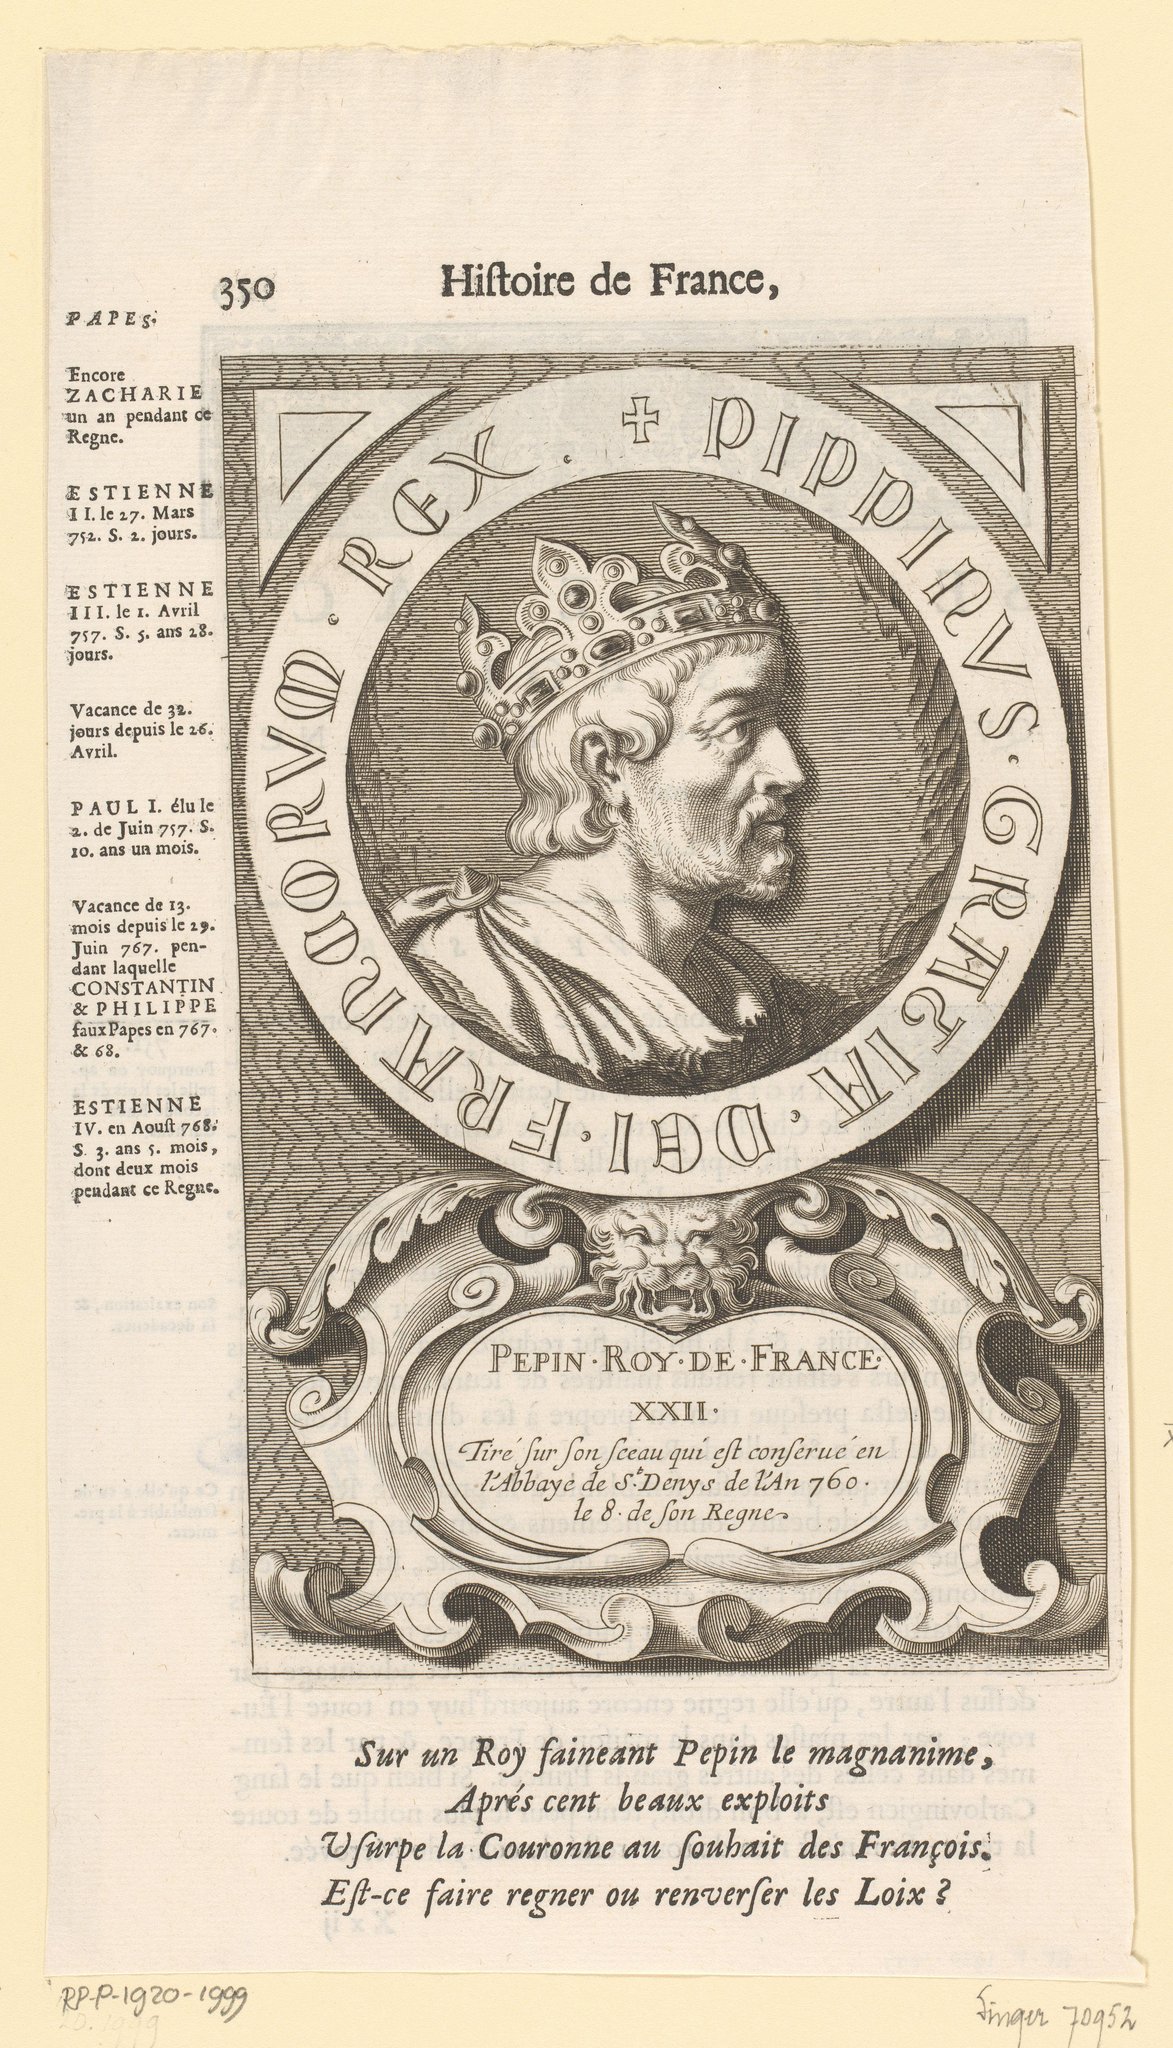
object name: print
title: Pepin roy de France XXII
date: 1635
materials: paper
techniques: engraving, letterpress printing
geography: paris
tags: historical persons, ruler, sovereign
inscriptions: collector's mark: Lugt 2228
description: Prent uit: Eudes de Mézeray, François. Histoire de France, depuis Faramond jusqu’au regne de Louis le Juste (...). 3 dln. Parijs: Denis Thierry, Jean Guignard en Claude Barbin, 1635, dl. 1. Prent waarschijnlijk voor het eerst verschenen in: Bie, Jacques de. Les vrais portraits des rois de France (...). Parijs: Jacques de Bie en Pierre Rocolet, 1634. Prent ook gebruikt in latere publicaties.